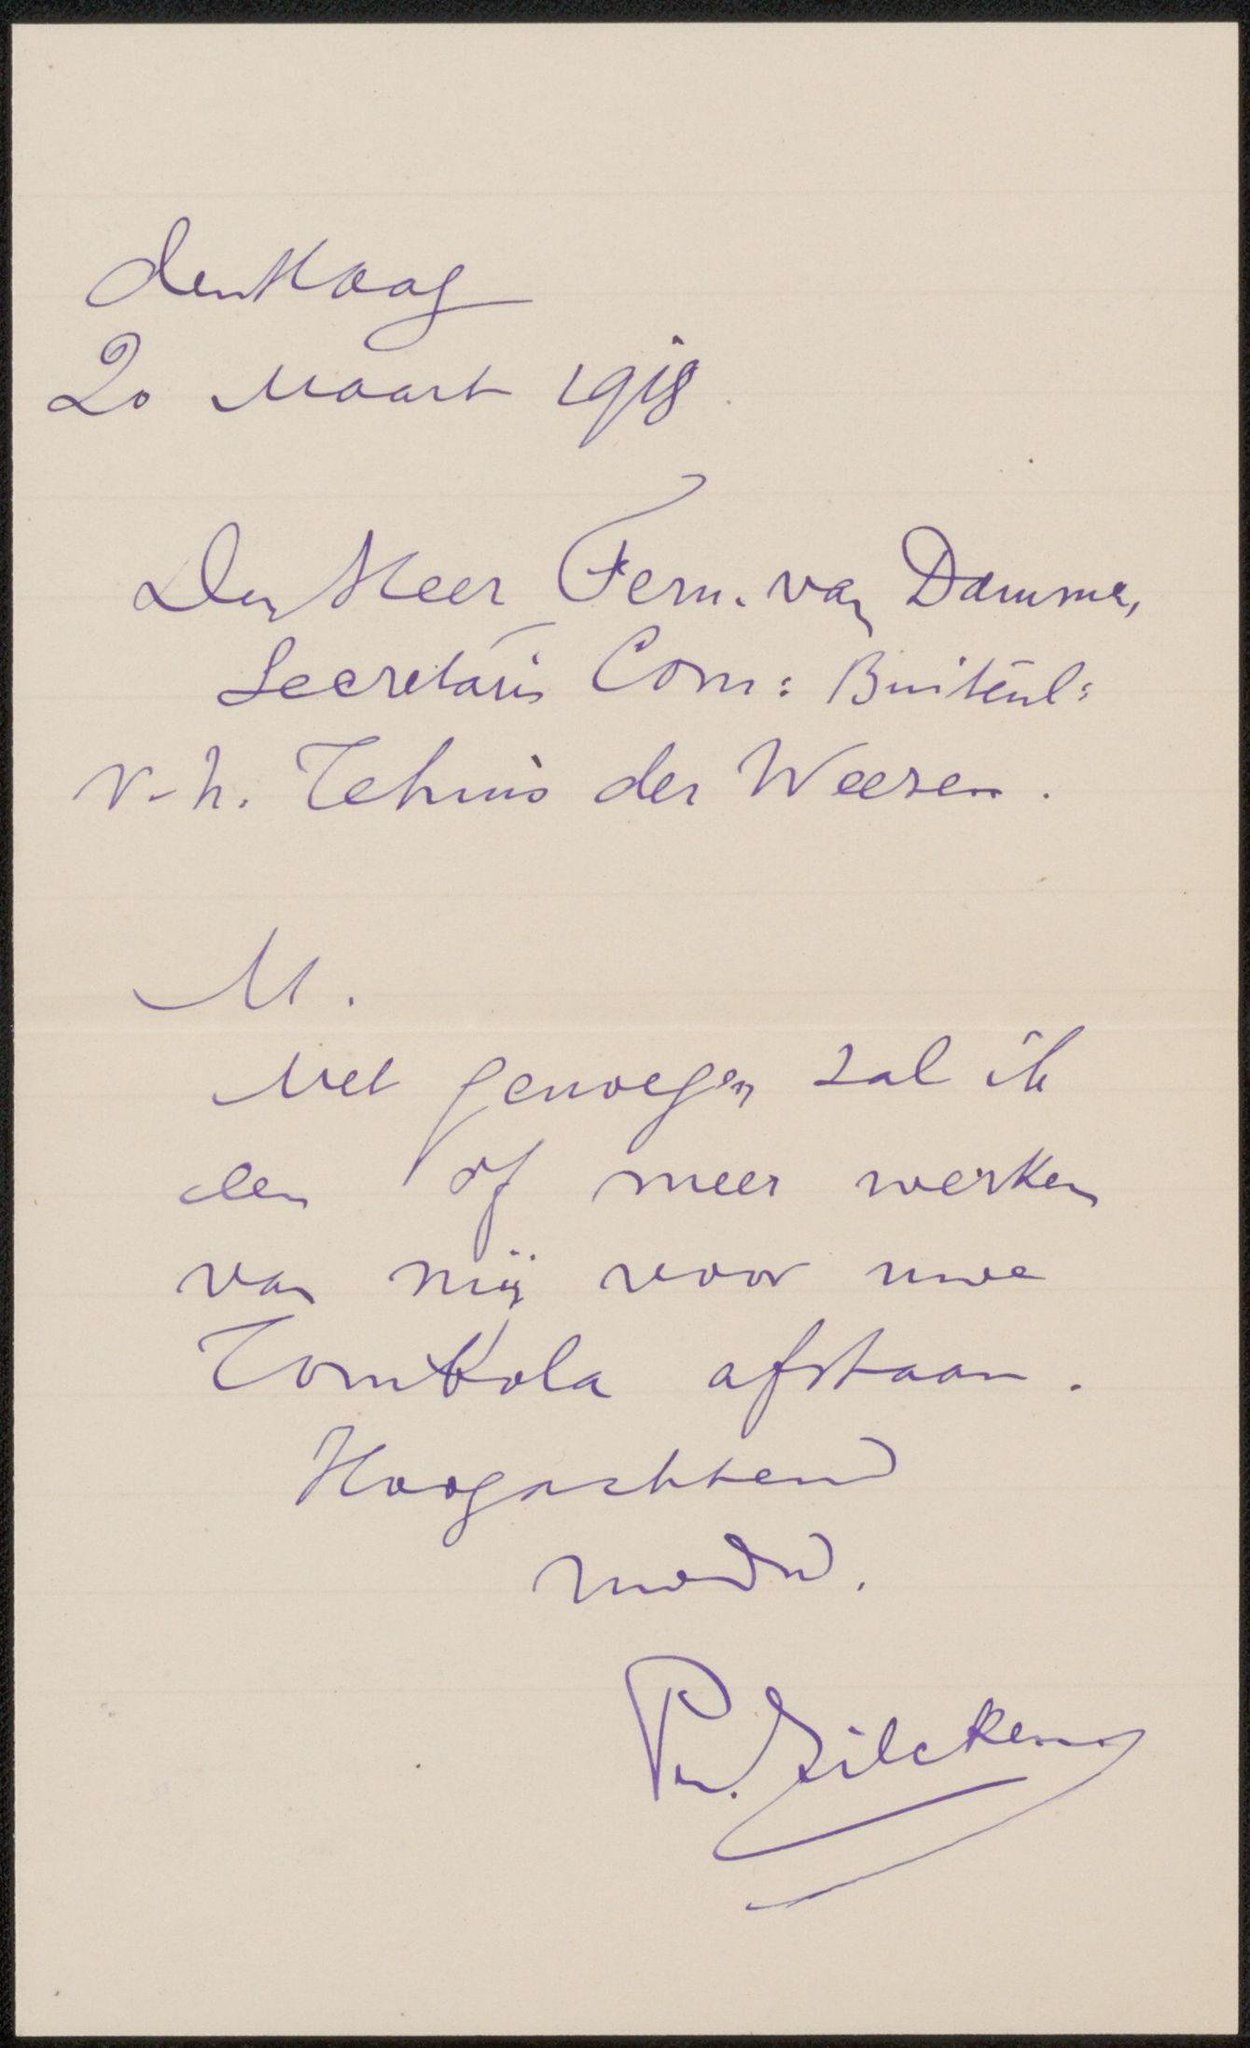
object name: letter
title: Brief aan F. van Damme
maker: philip zilcken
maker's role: draughtsman, painter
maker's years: 1857-1930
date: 1918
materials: ink, paper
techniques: pen, writing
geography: the hague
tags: charitable works